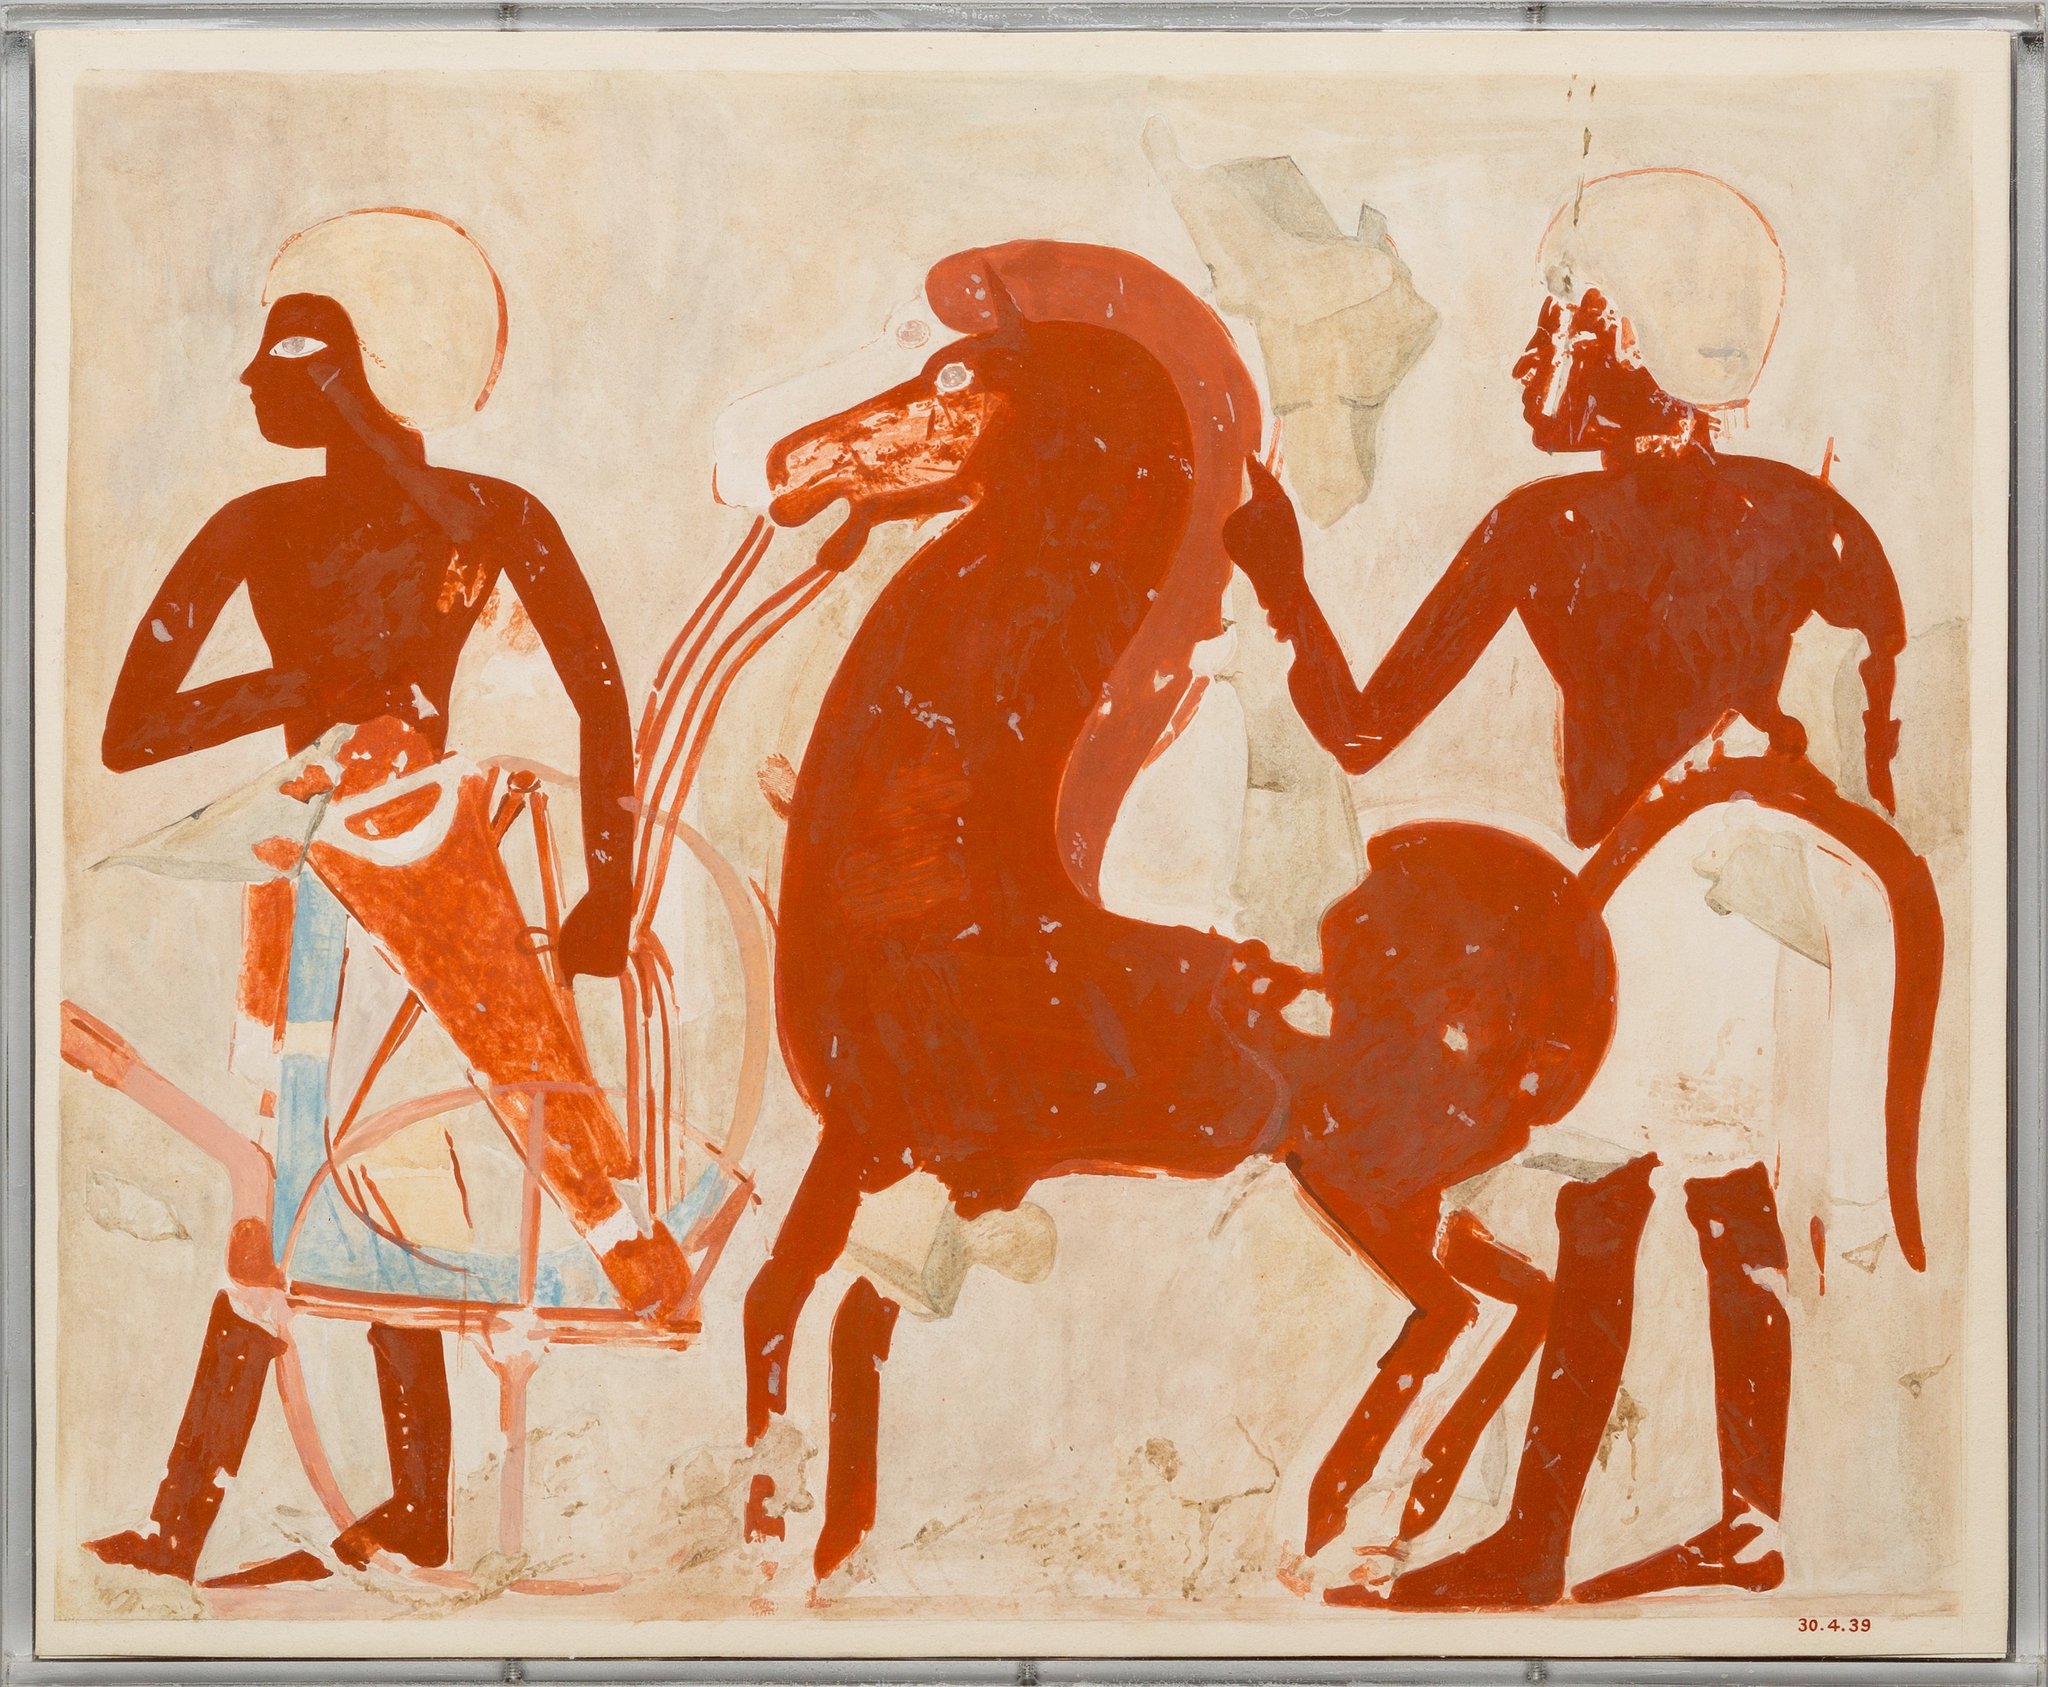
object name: facsimile, userhat tt 56, soldier, horse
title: Offerings of a Chariot and Horse, Tomb of Userhat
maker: charles k. wilkinson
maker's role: artist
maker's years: 1897-1986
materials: paper, paint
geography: egypt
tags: men,horses,chariots,love-poetry